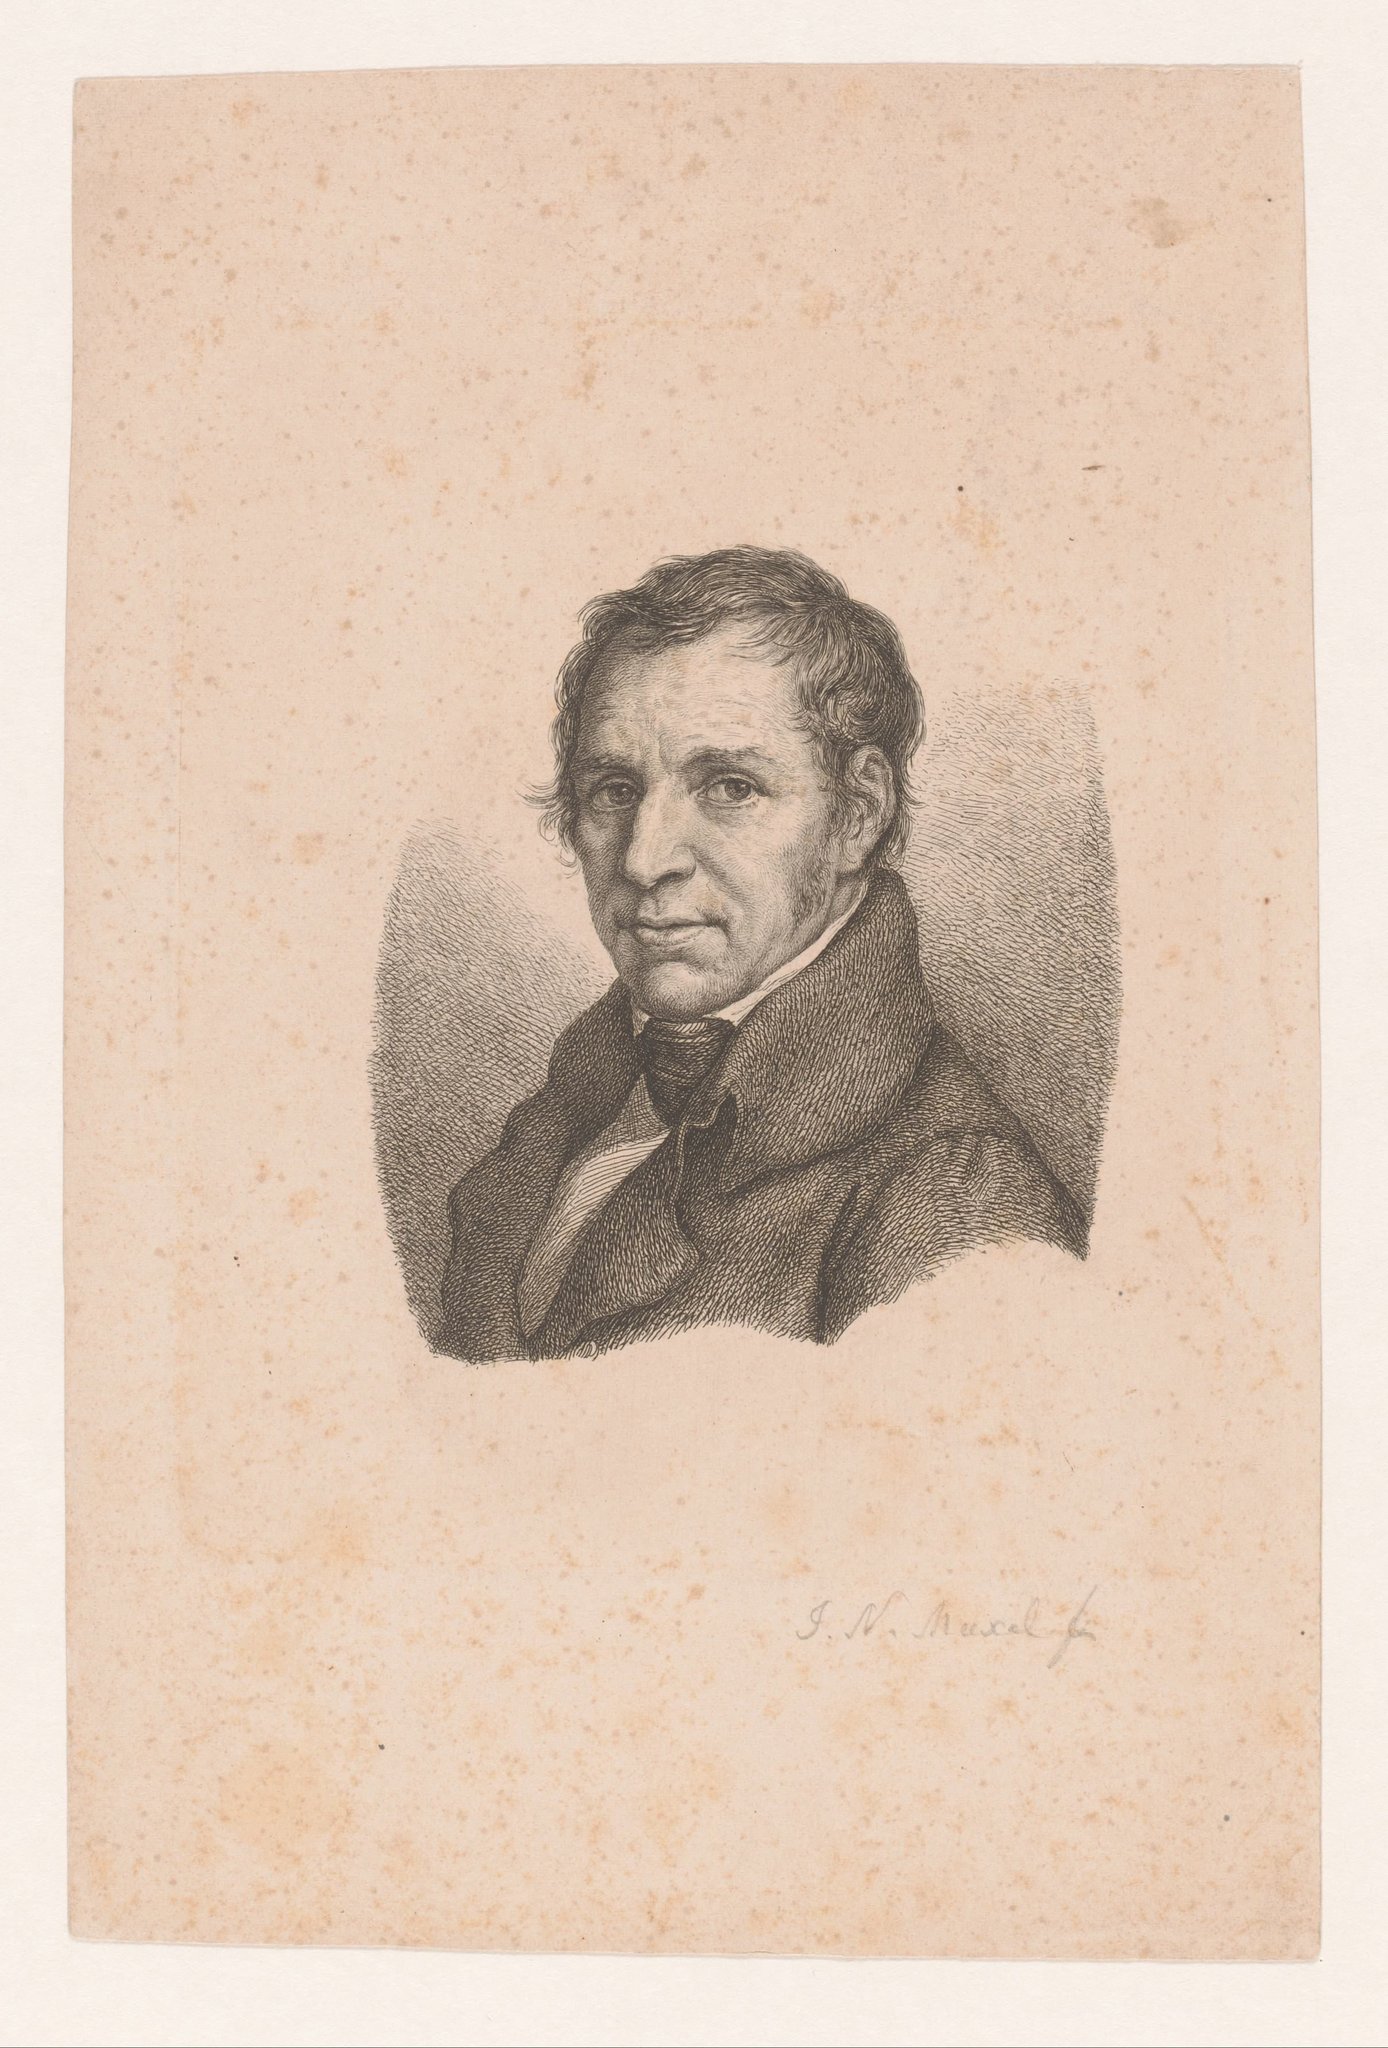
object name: print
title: Portret van een onbekende man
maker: johann nepomuk muxel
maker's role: print maker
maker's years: 1790-1870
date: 1800-1870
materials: paper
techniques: etching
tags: historical persons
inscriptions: collector's mark: Lugt 2228